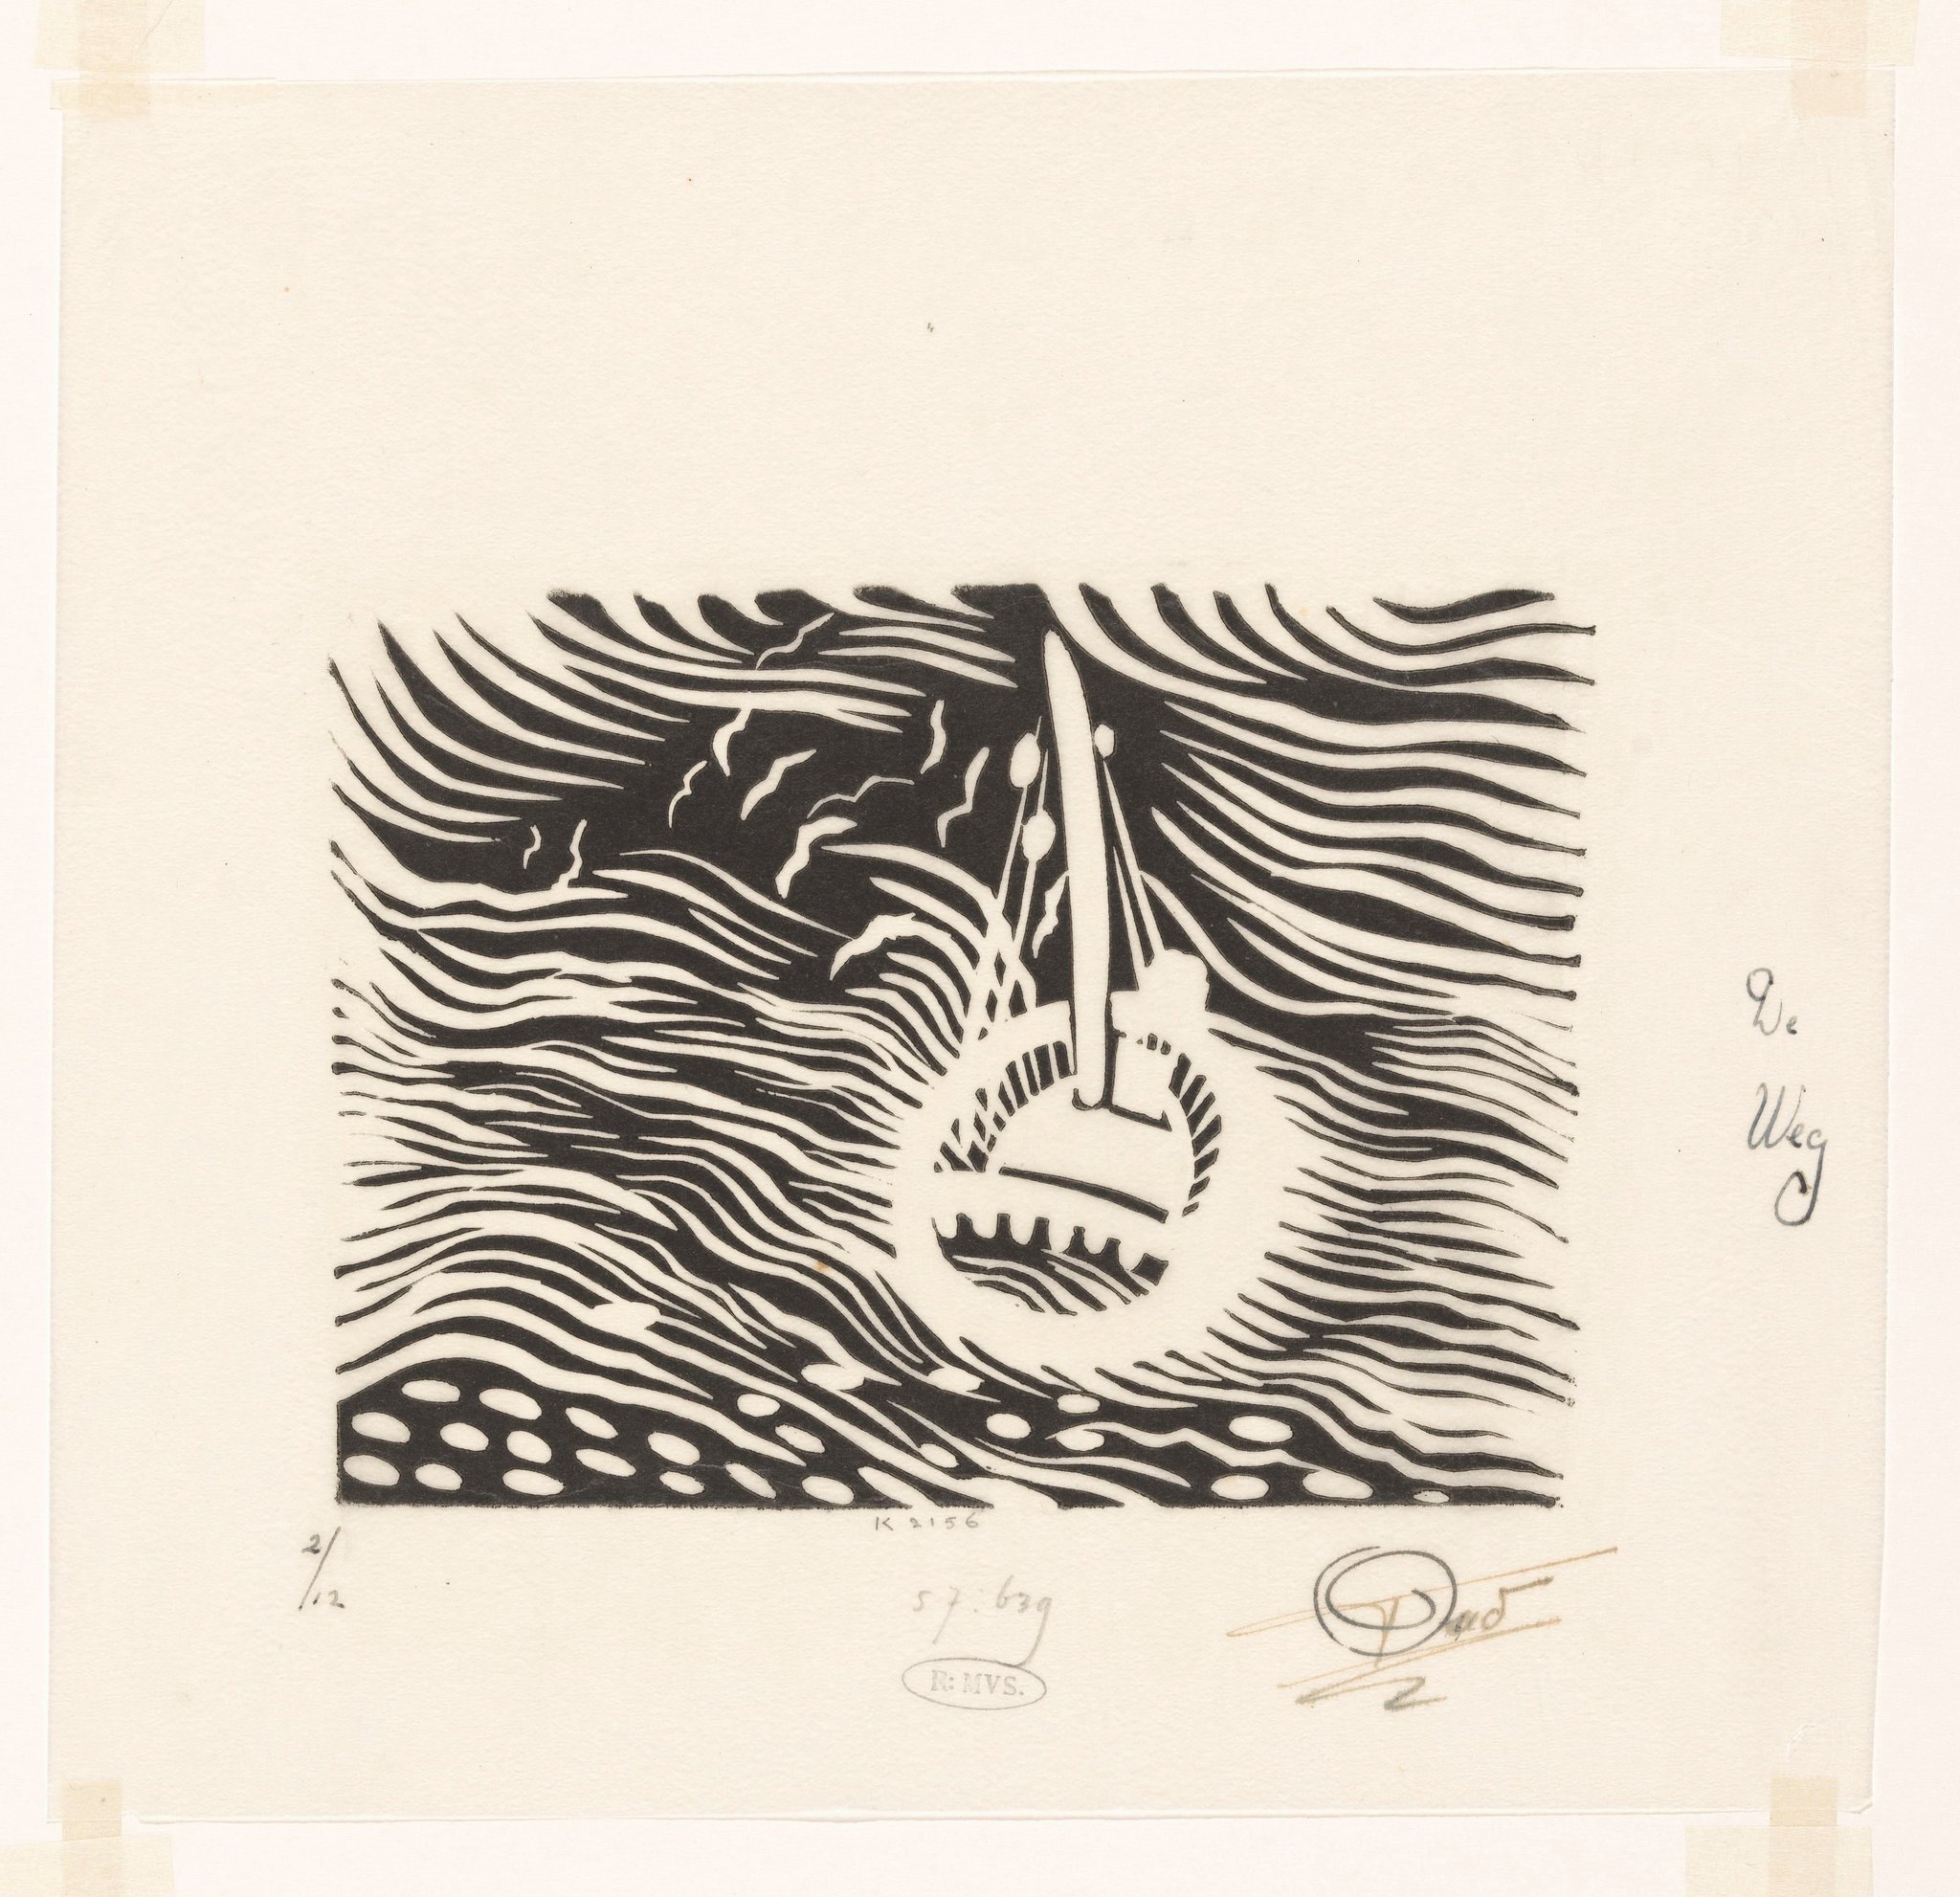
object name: print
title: De weg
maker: tames oud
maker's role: print maker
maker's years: 1895-1953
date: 1905-1953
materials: paper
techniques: woodcut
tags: wave, sailing-ship, sailing-boat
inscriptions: collector's mark: Lugt 2228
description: Een zeilschip in de golven. In de lucht meeuwen.